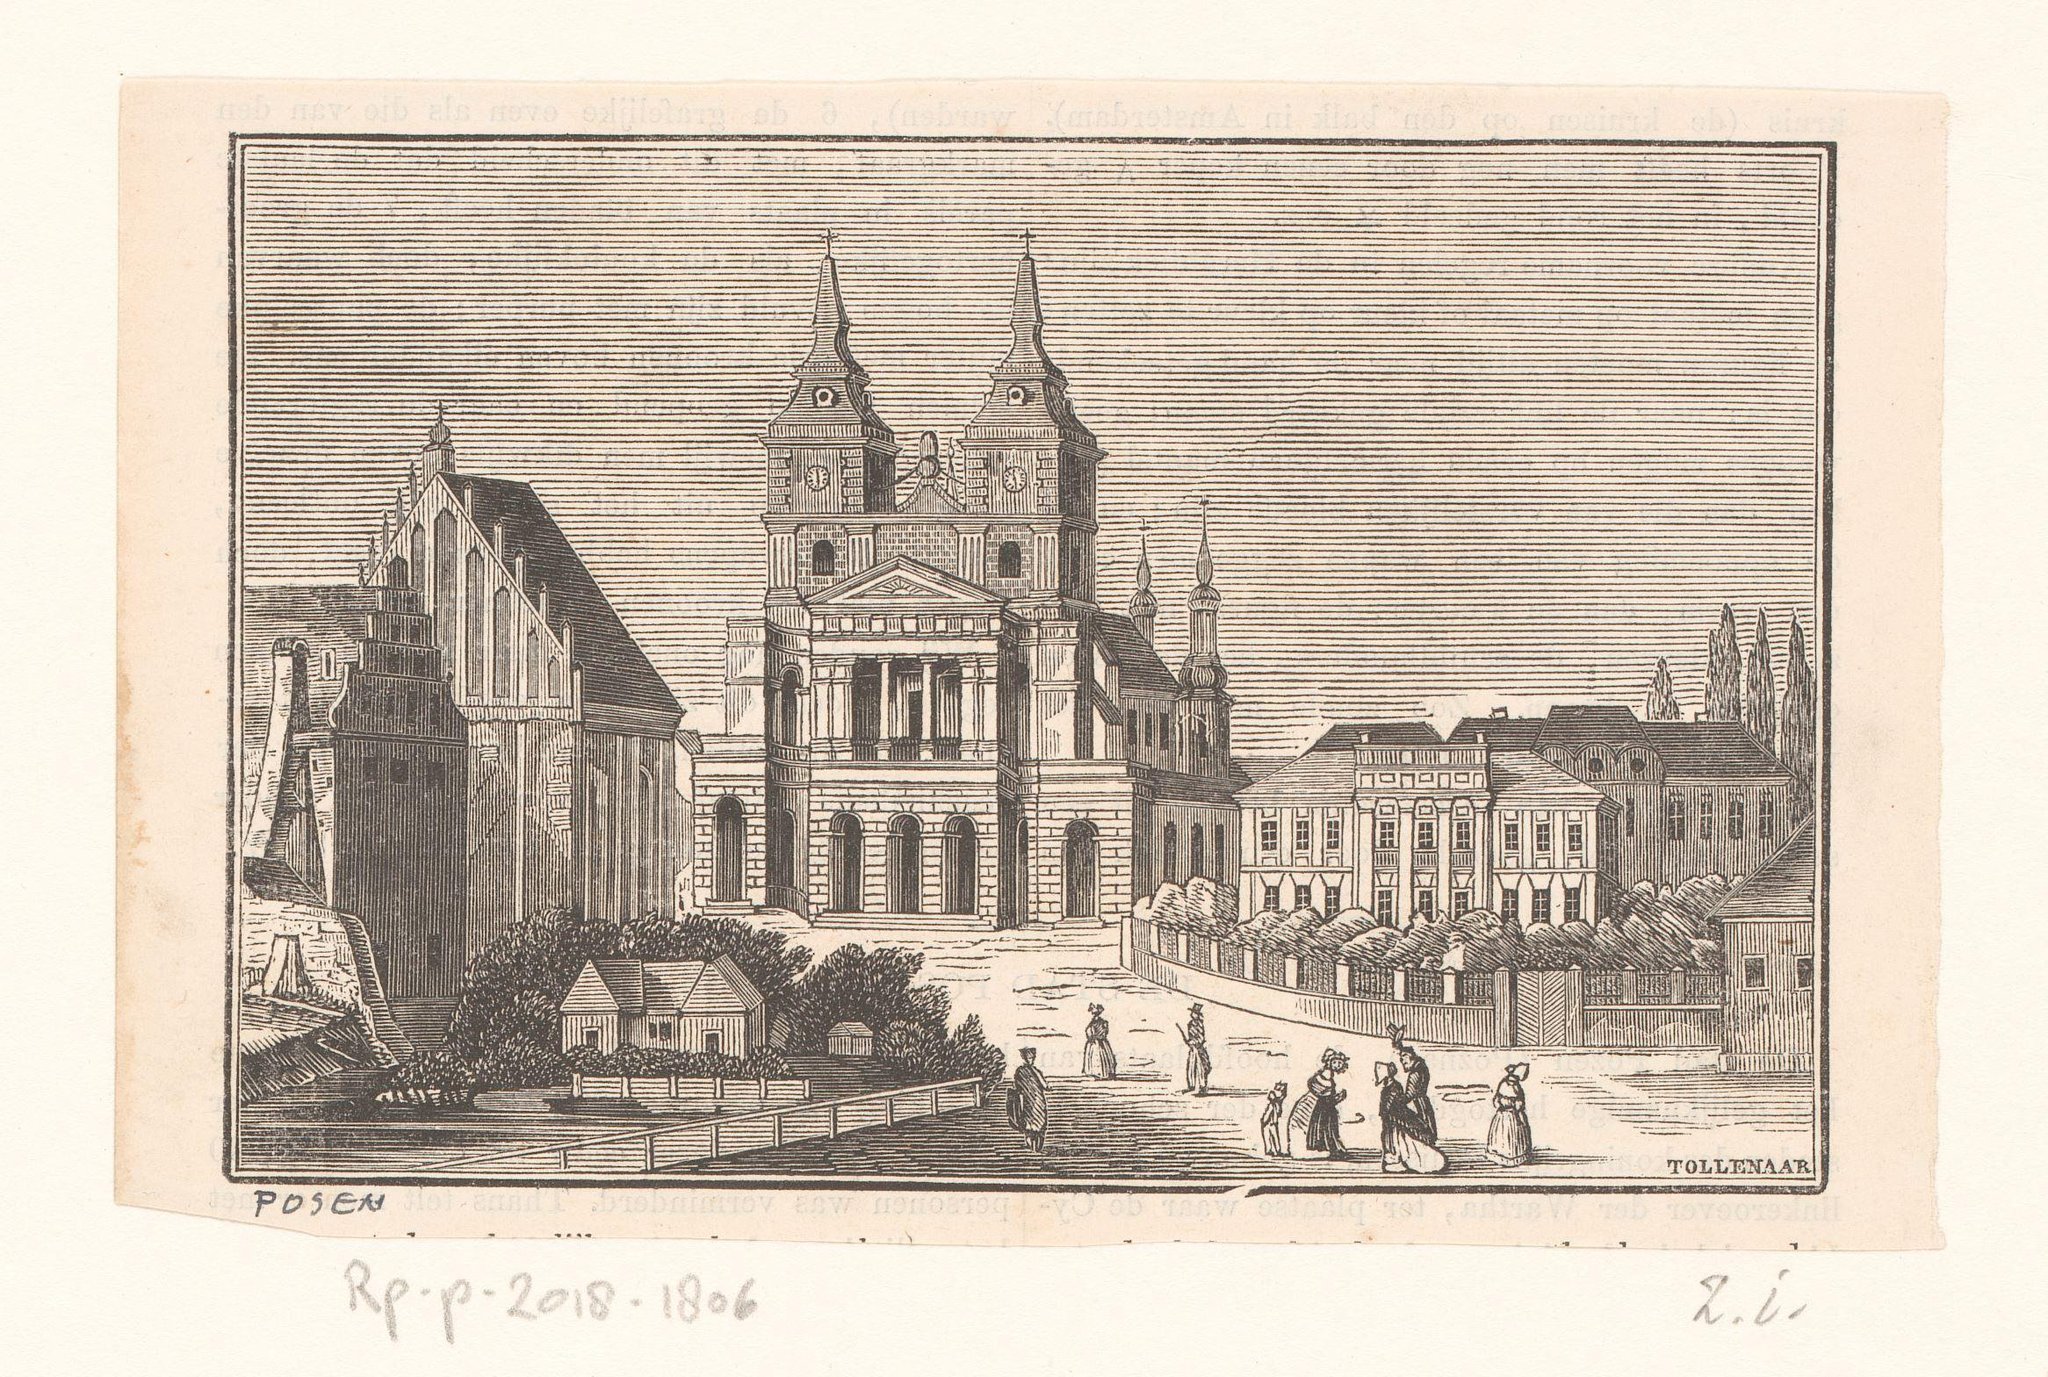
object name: print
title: Gezicht op de Sint-Petrus-en-Paulusbasiliek, te Poznań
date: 1847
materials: paper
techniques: letterpress printing, engraving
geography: amsterdam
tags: church (exterior)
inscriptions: collector's mark: Lugt 2228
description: Prent gebruikt in: Hollandsch Penning-Magazijn voor de jeugd. Amsterdam: J.H. Laarman, 1847.